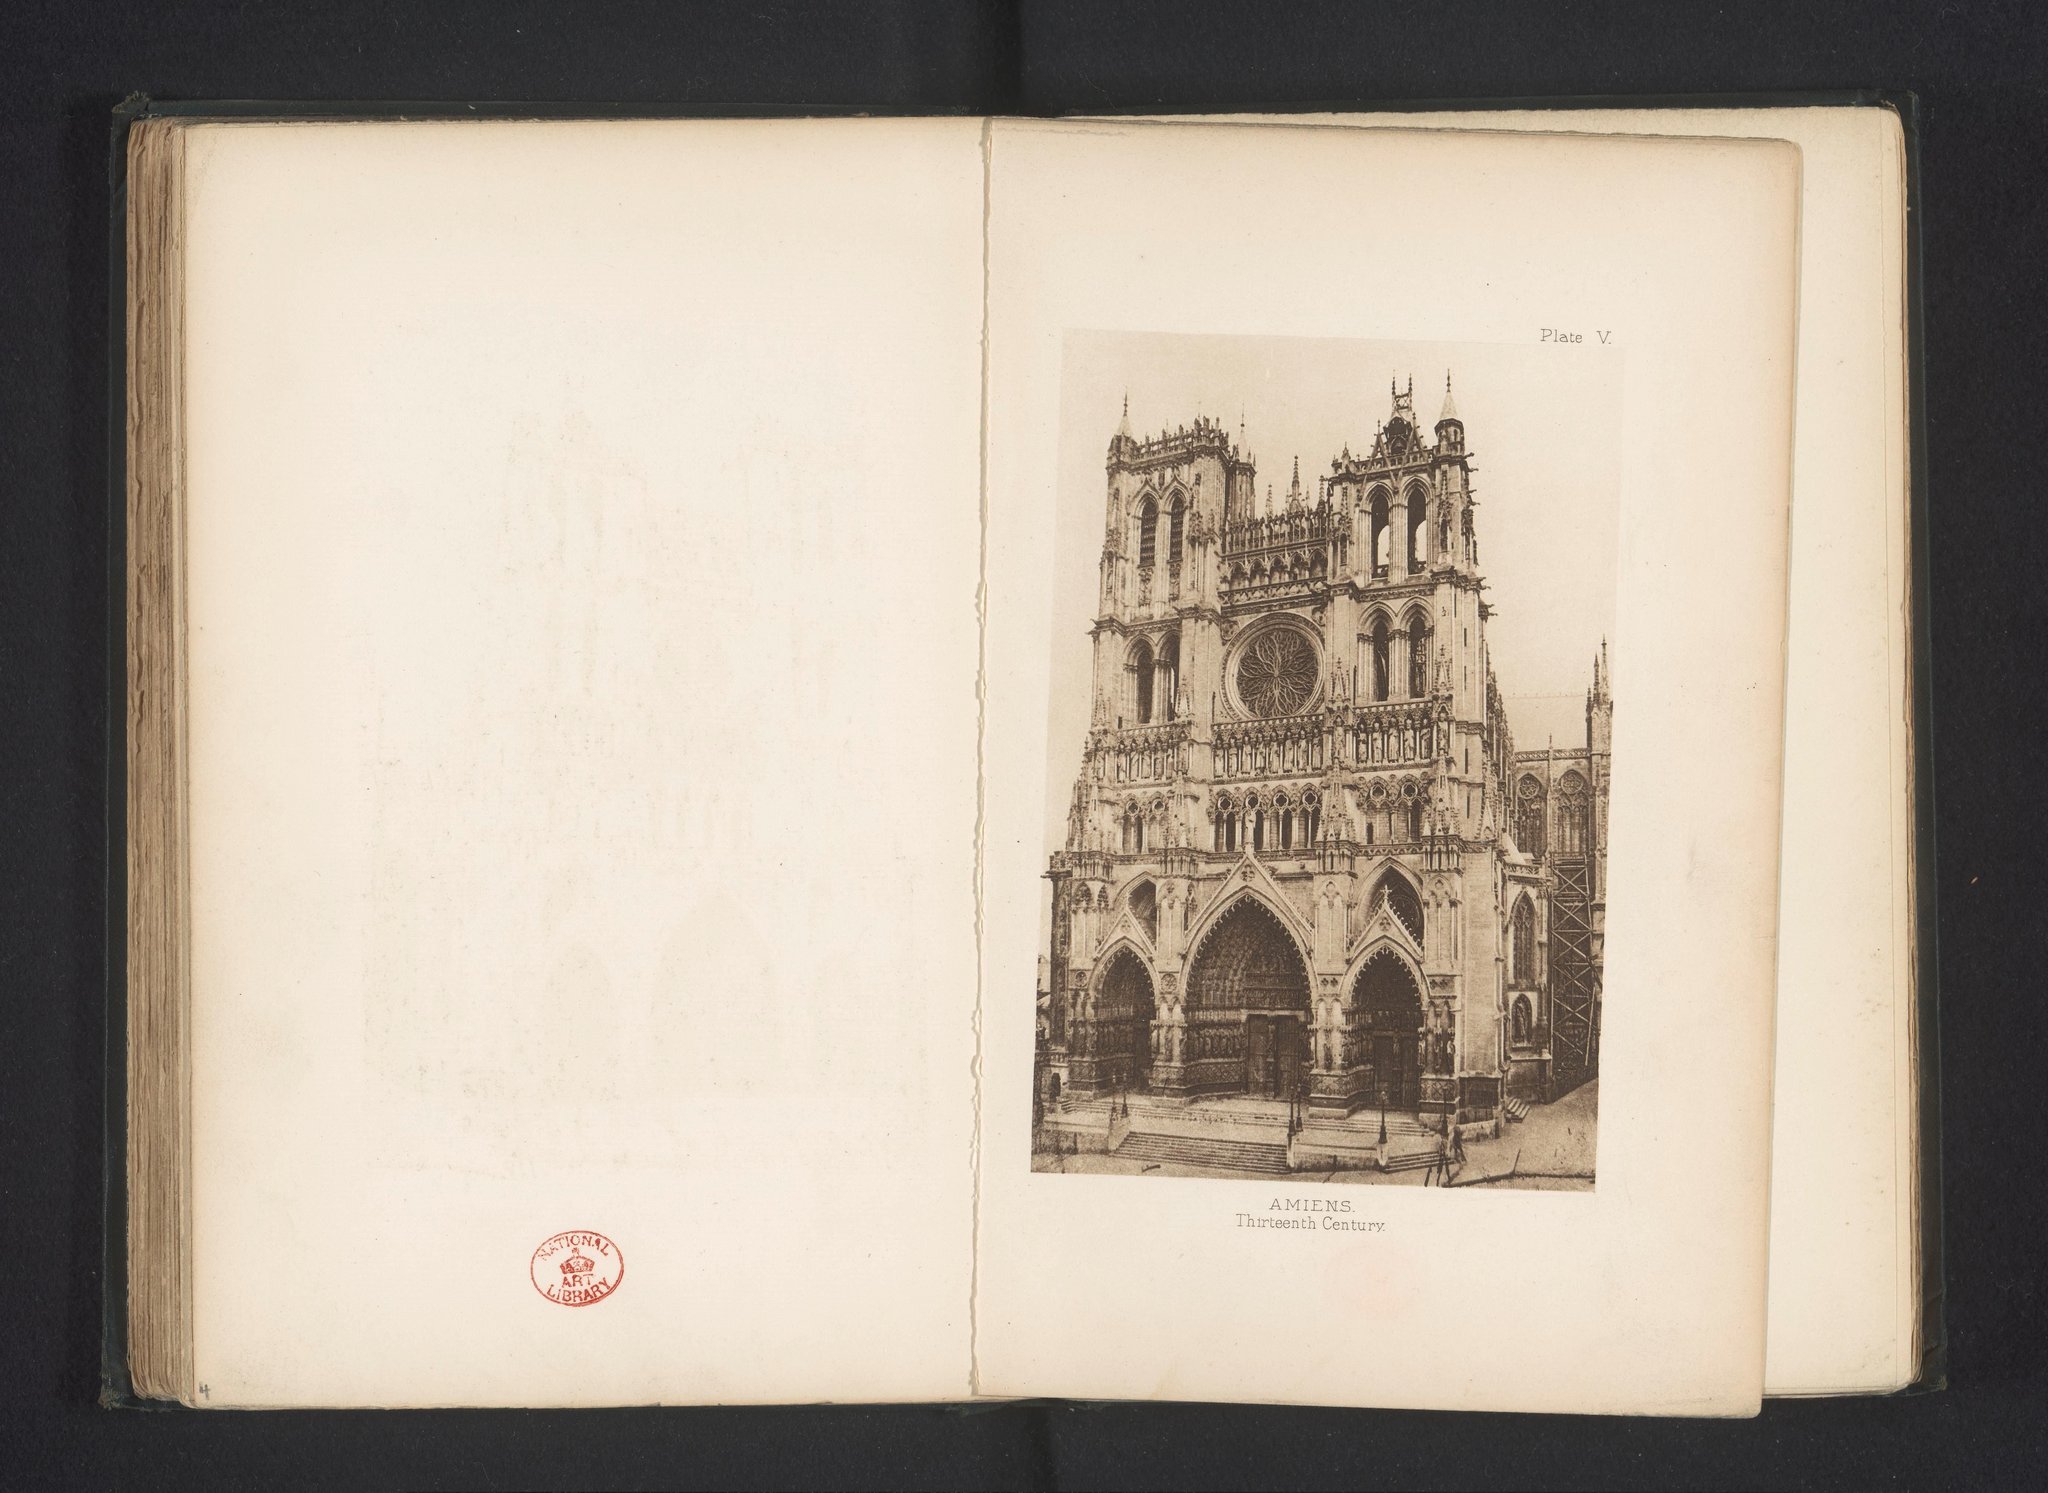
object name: photomechanical print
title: Amiens. Thirteenth Century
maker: Anonymous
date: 1880-1890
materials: paper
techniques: photoaquatint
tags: parts of church exterior and annexes: façade, notre-dame d'amiens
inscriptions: name: ‘National Art Library’, number: ‘PLate V.’